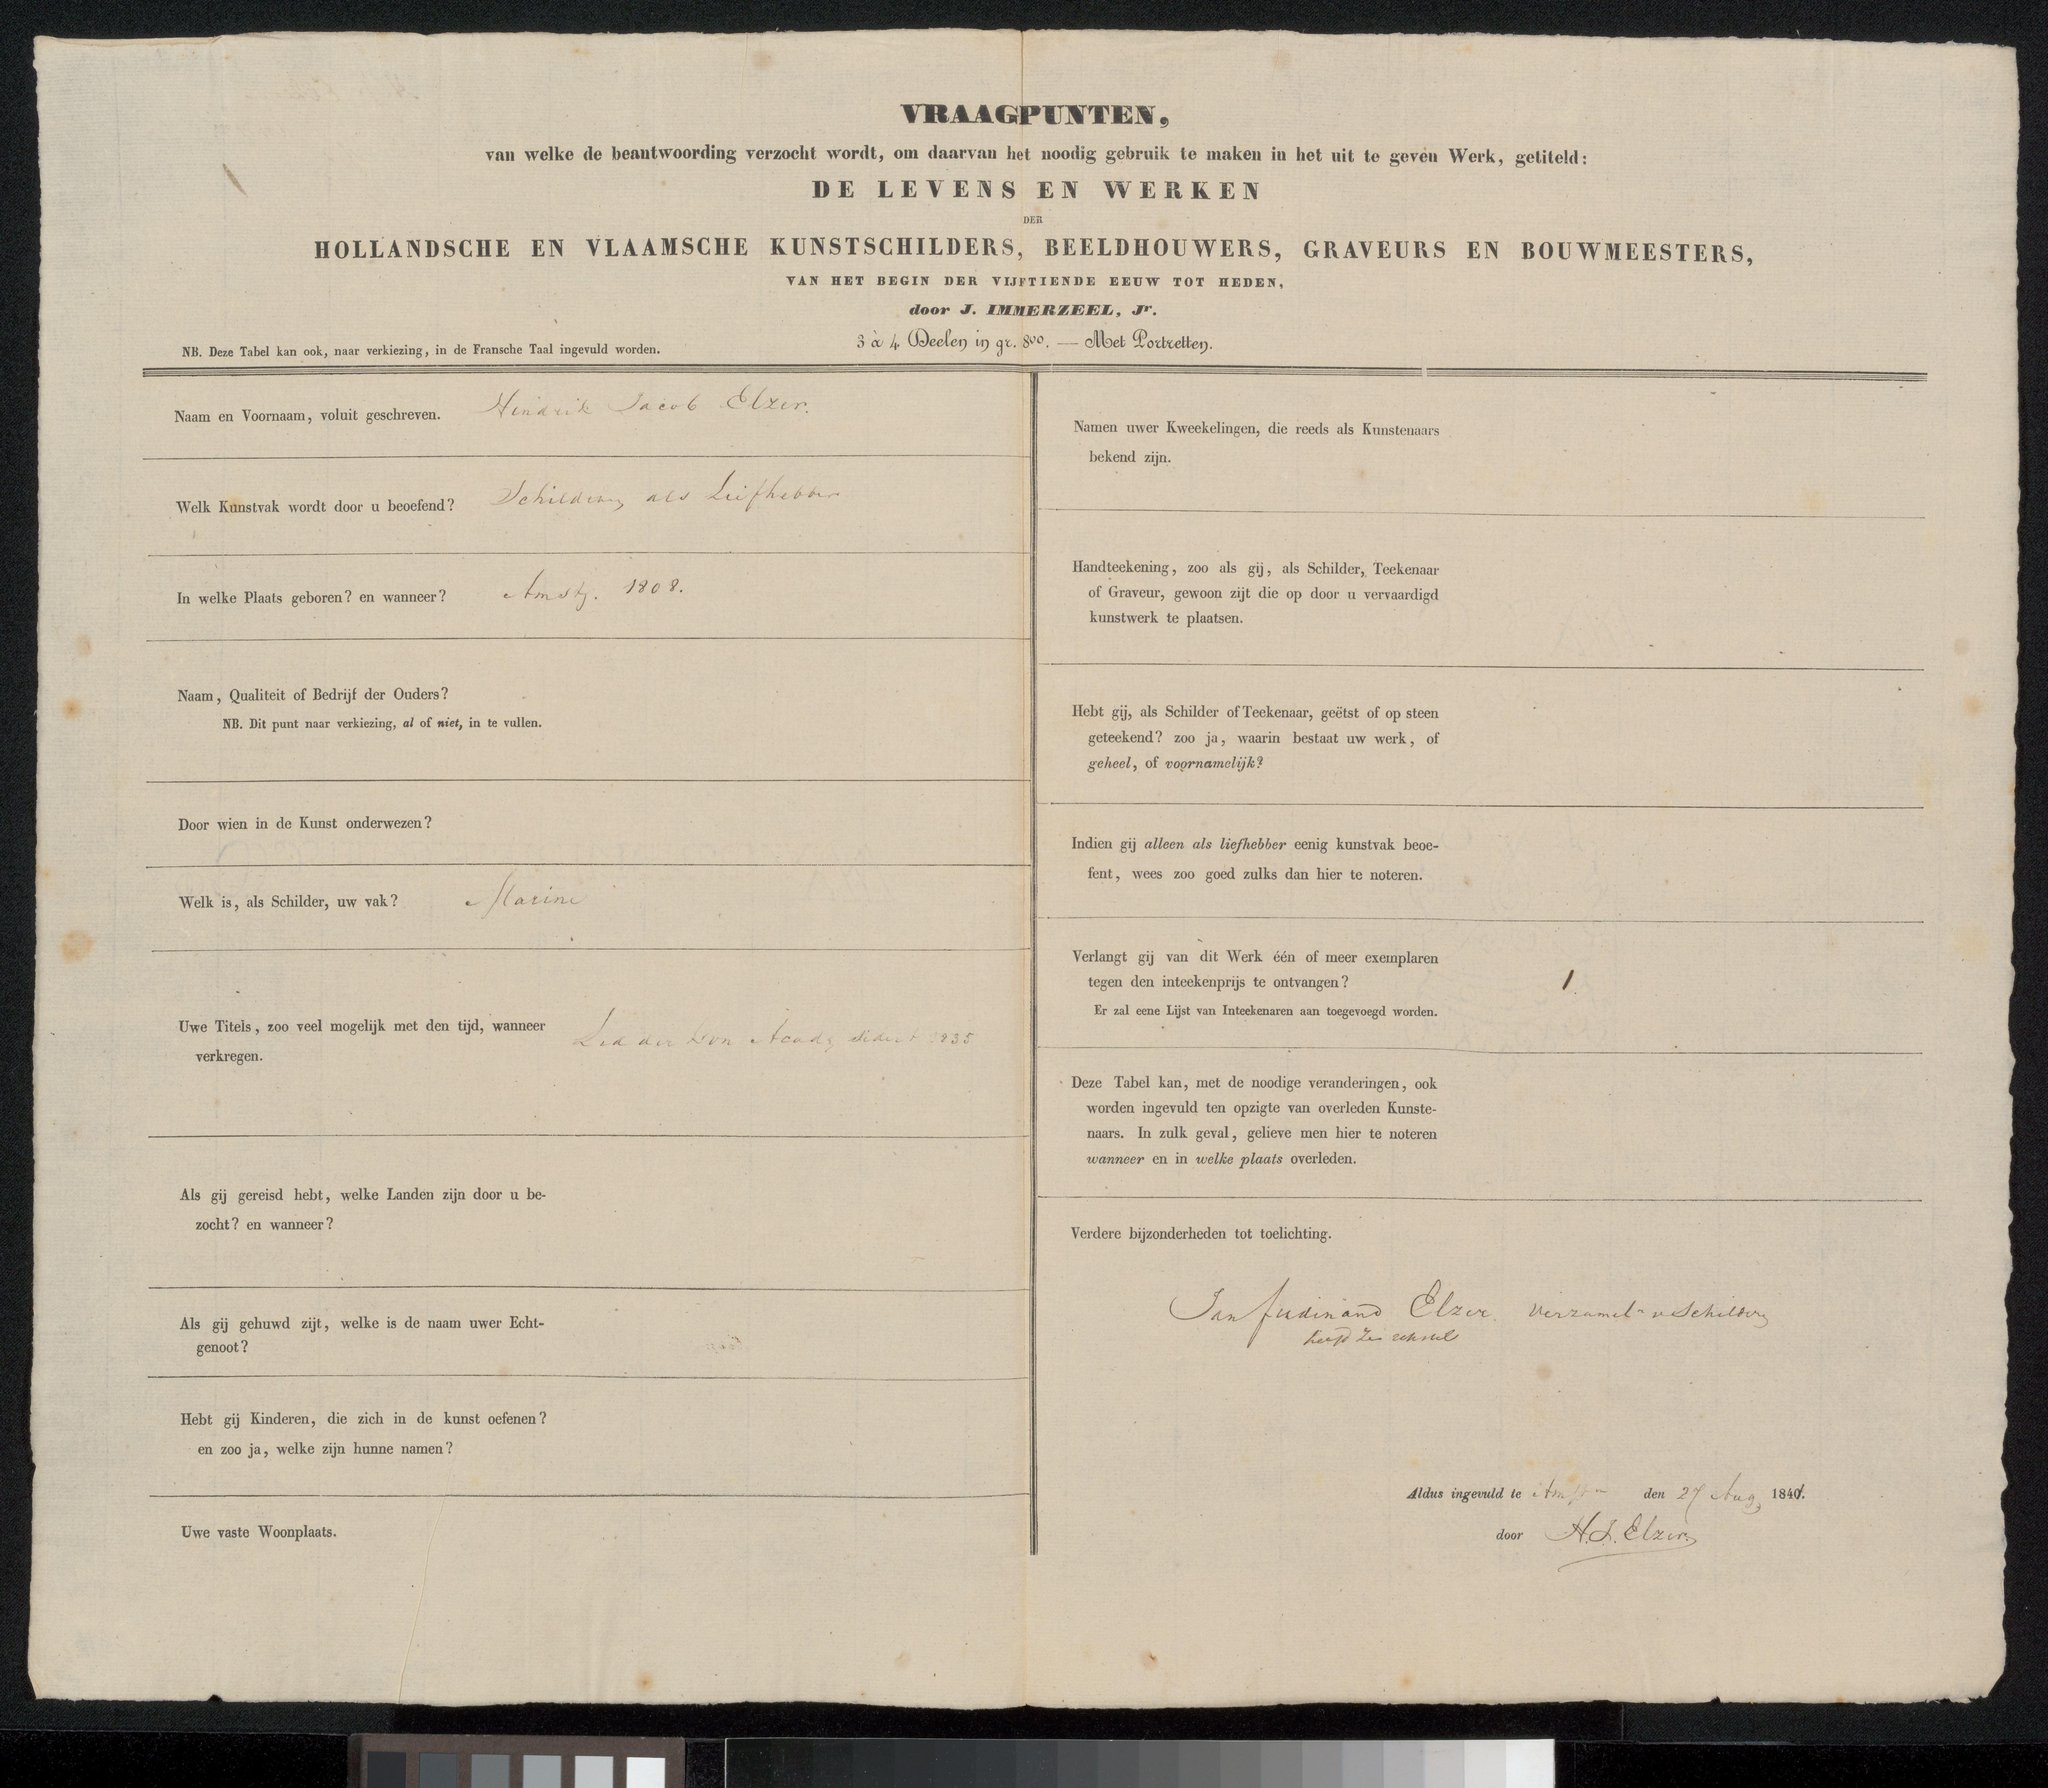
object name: questionnaire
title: Enquêteformulier ingevuld door Hendrik Jacob Elzer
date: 1841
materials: ink, paper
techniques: pen, printing, writing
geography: amsterdam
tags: painter, draughtsman, hendrik jacob elzer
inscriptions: inscription: ‘Vraagpunten,/ van welke de beantwoording verzocht wordt, om daarvan het noodig gebruik te maken in het uit te geven Werk, getiteld: De levens en werken/ der Hollandsche en Vlaamsche kunstschilders, beeldhouwers,/ graveurs en bouwmeesters, van het begin der vijftiende eeuw tot heden/ door J. Immerzeel, Jr.’, watermark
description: Opgenomen in: Immerzeel, J. Jr., De levens en werken der Hollandsche en Vlaamsche kunstschilders, beeldhouwers, graveurs en bouwmeesters, van het begin der vijftiende eeuw tot heden, Amsterdam: J.C. van Kesteren, 1842-1843.